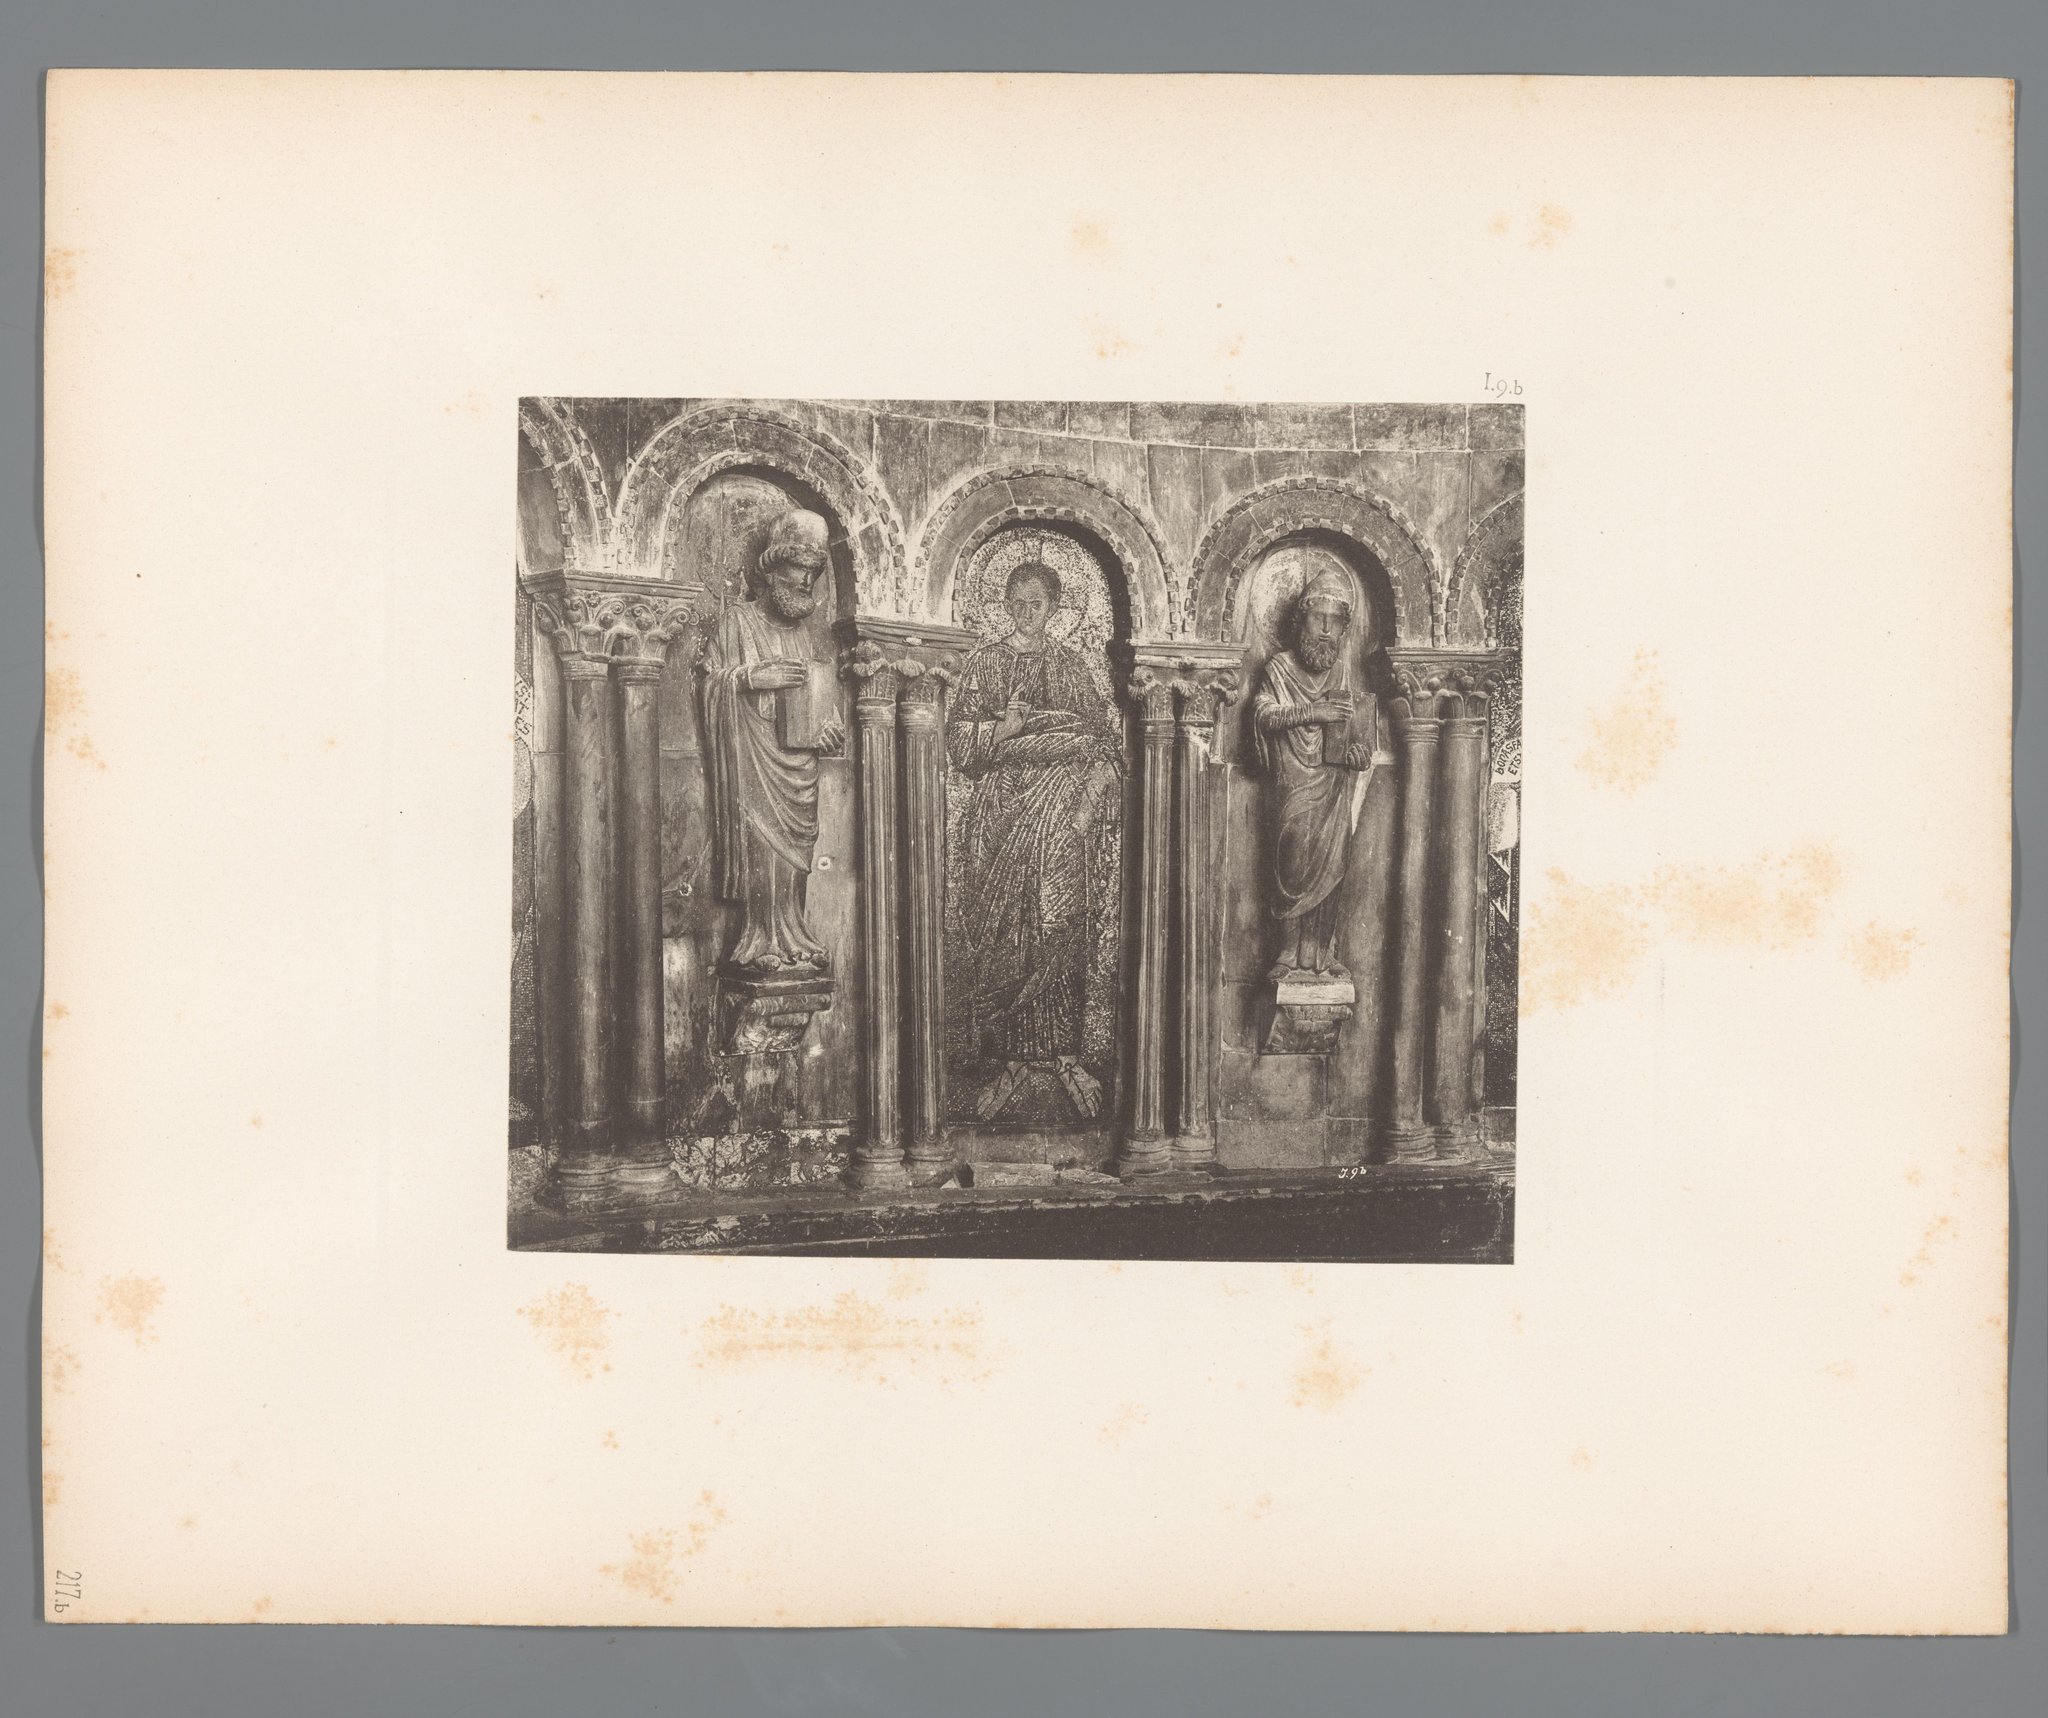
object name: photomechanical print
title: Twee sculpturen en een mozaïek, vermoedelijk van apostelen, van de San Marco in Venetië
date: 1880-1885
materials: paper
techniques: photograph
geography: venice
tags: architectural detail, piece of sculpture, reproduction of a piece of sculpture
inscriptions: number: ‘217.b’, number: ‘J.9b’, number: ‘I.9.b’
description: Deze prent maakt deel uit van een omslag met 79 prenten op 53 bladen en 2 tekstbladen.